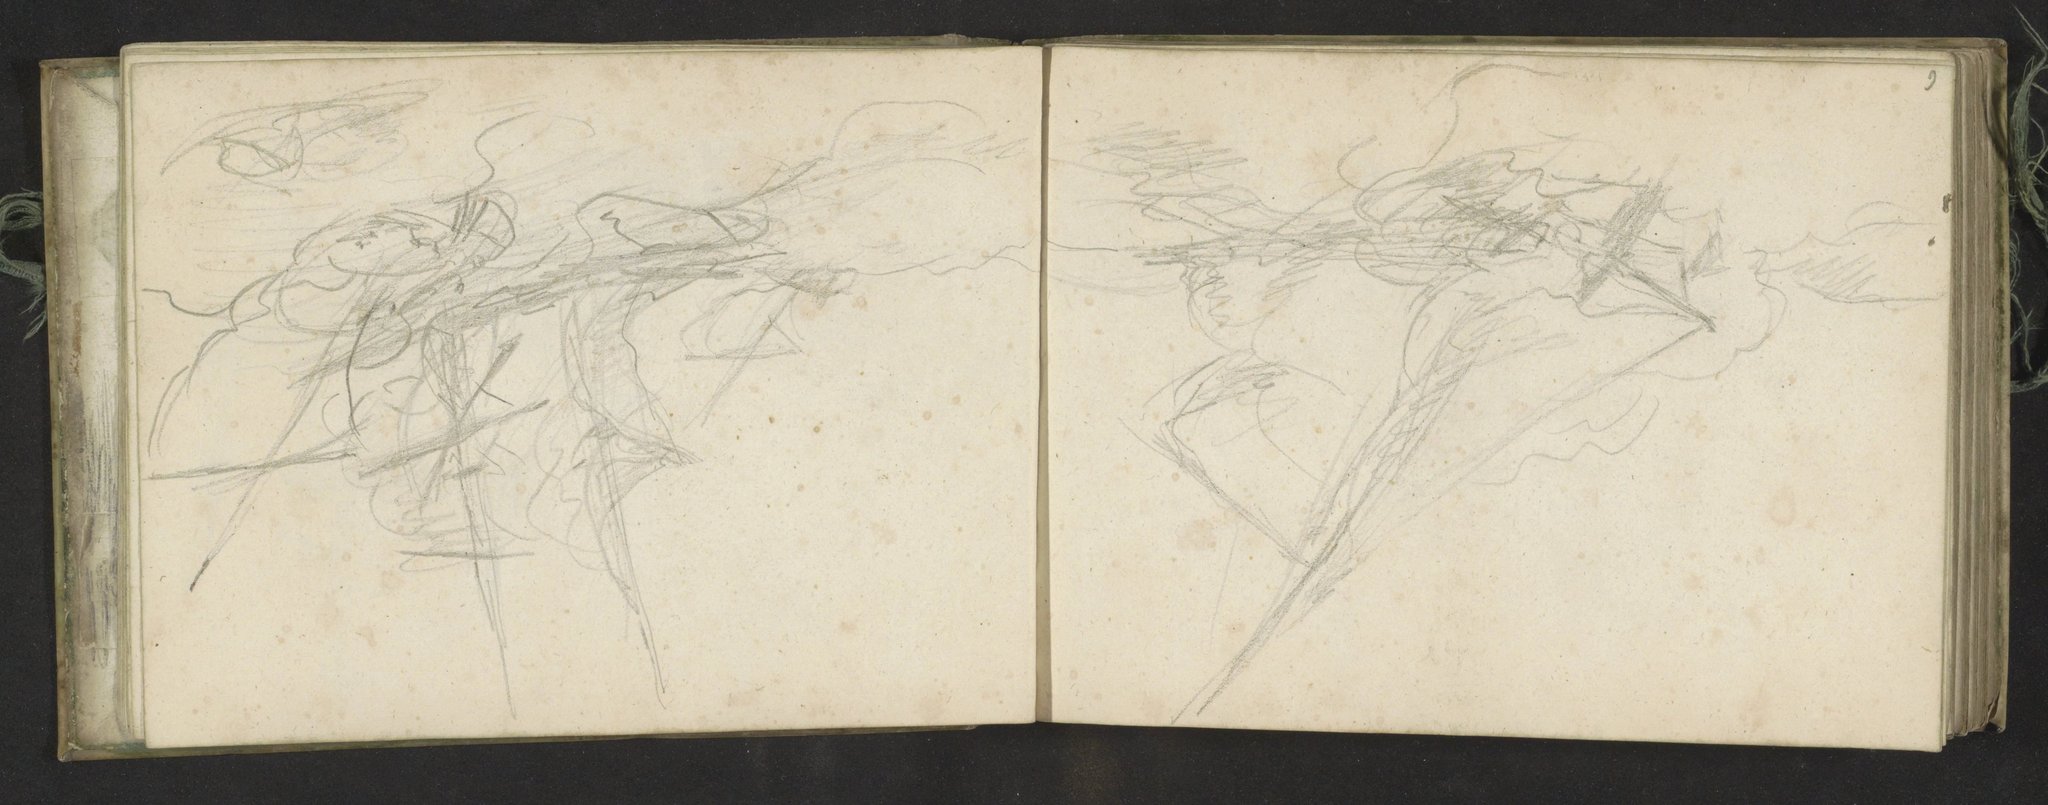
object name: sketchbook leaf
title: Drie zeilschepen op een woelige zee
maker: martinus schouman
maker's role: draughtsman, painter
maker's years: 1770-1848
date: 1780-1848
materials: paper, pencil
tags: sailing-ship, sailing-boat, storm at sea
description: Blad 8 verso en 9 recto uit een schetsboek met 53 bladen.